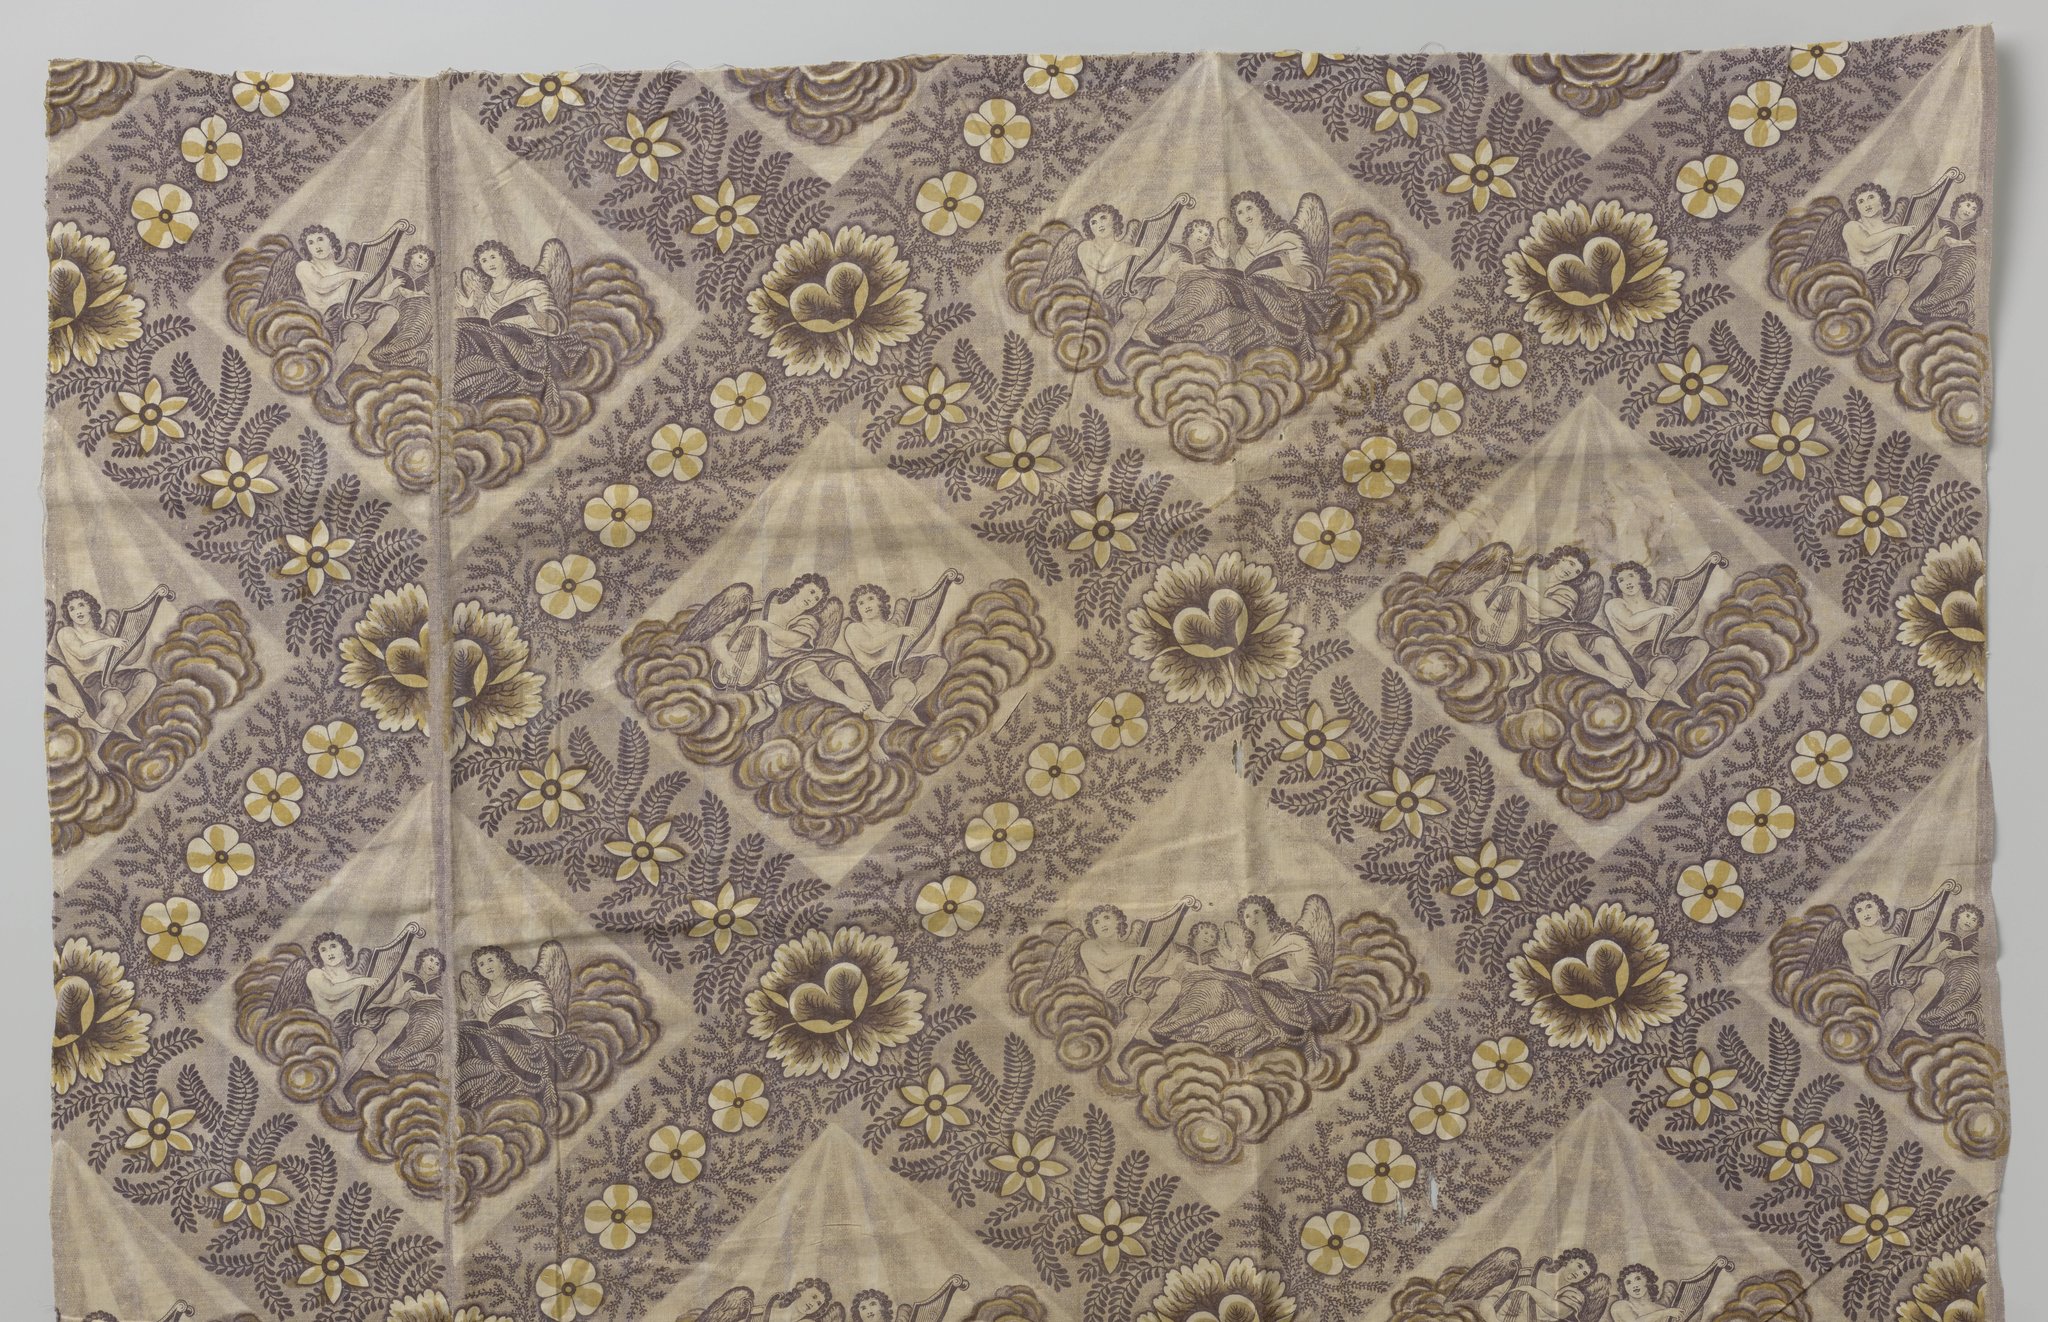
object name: lap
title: Lap bedrukte katoen met patroon van lier- en harpspelende engelen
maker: Anonymous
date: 1840-1860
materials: cotton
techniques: printing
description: Kleed of lap van in geel en paars bedrukte witte katoen met lier- en harpspelende en zingende engelen binnen een ruitvormige, met bloemen gevulde omlijsting